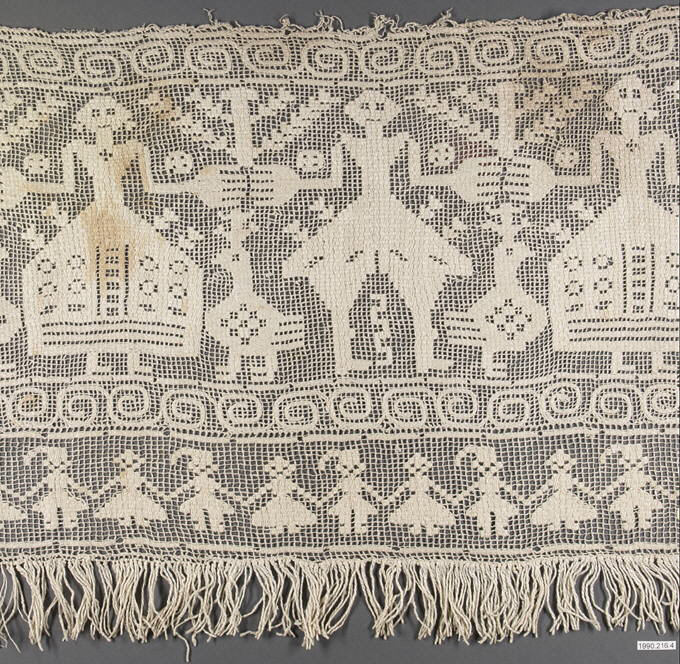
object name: border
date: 1501-1600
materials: linen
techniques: embroidery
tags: birds,men,women